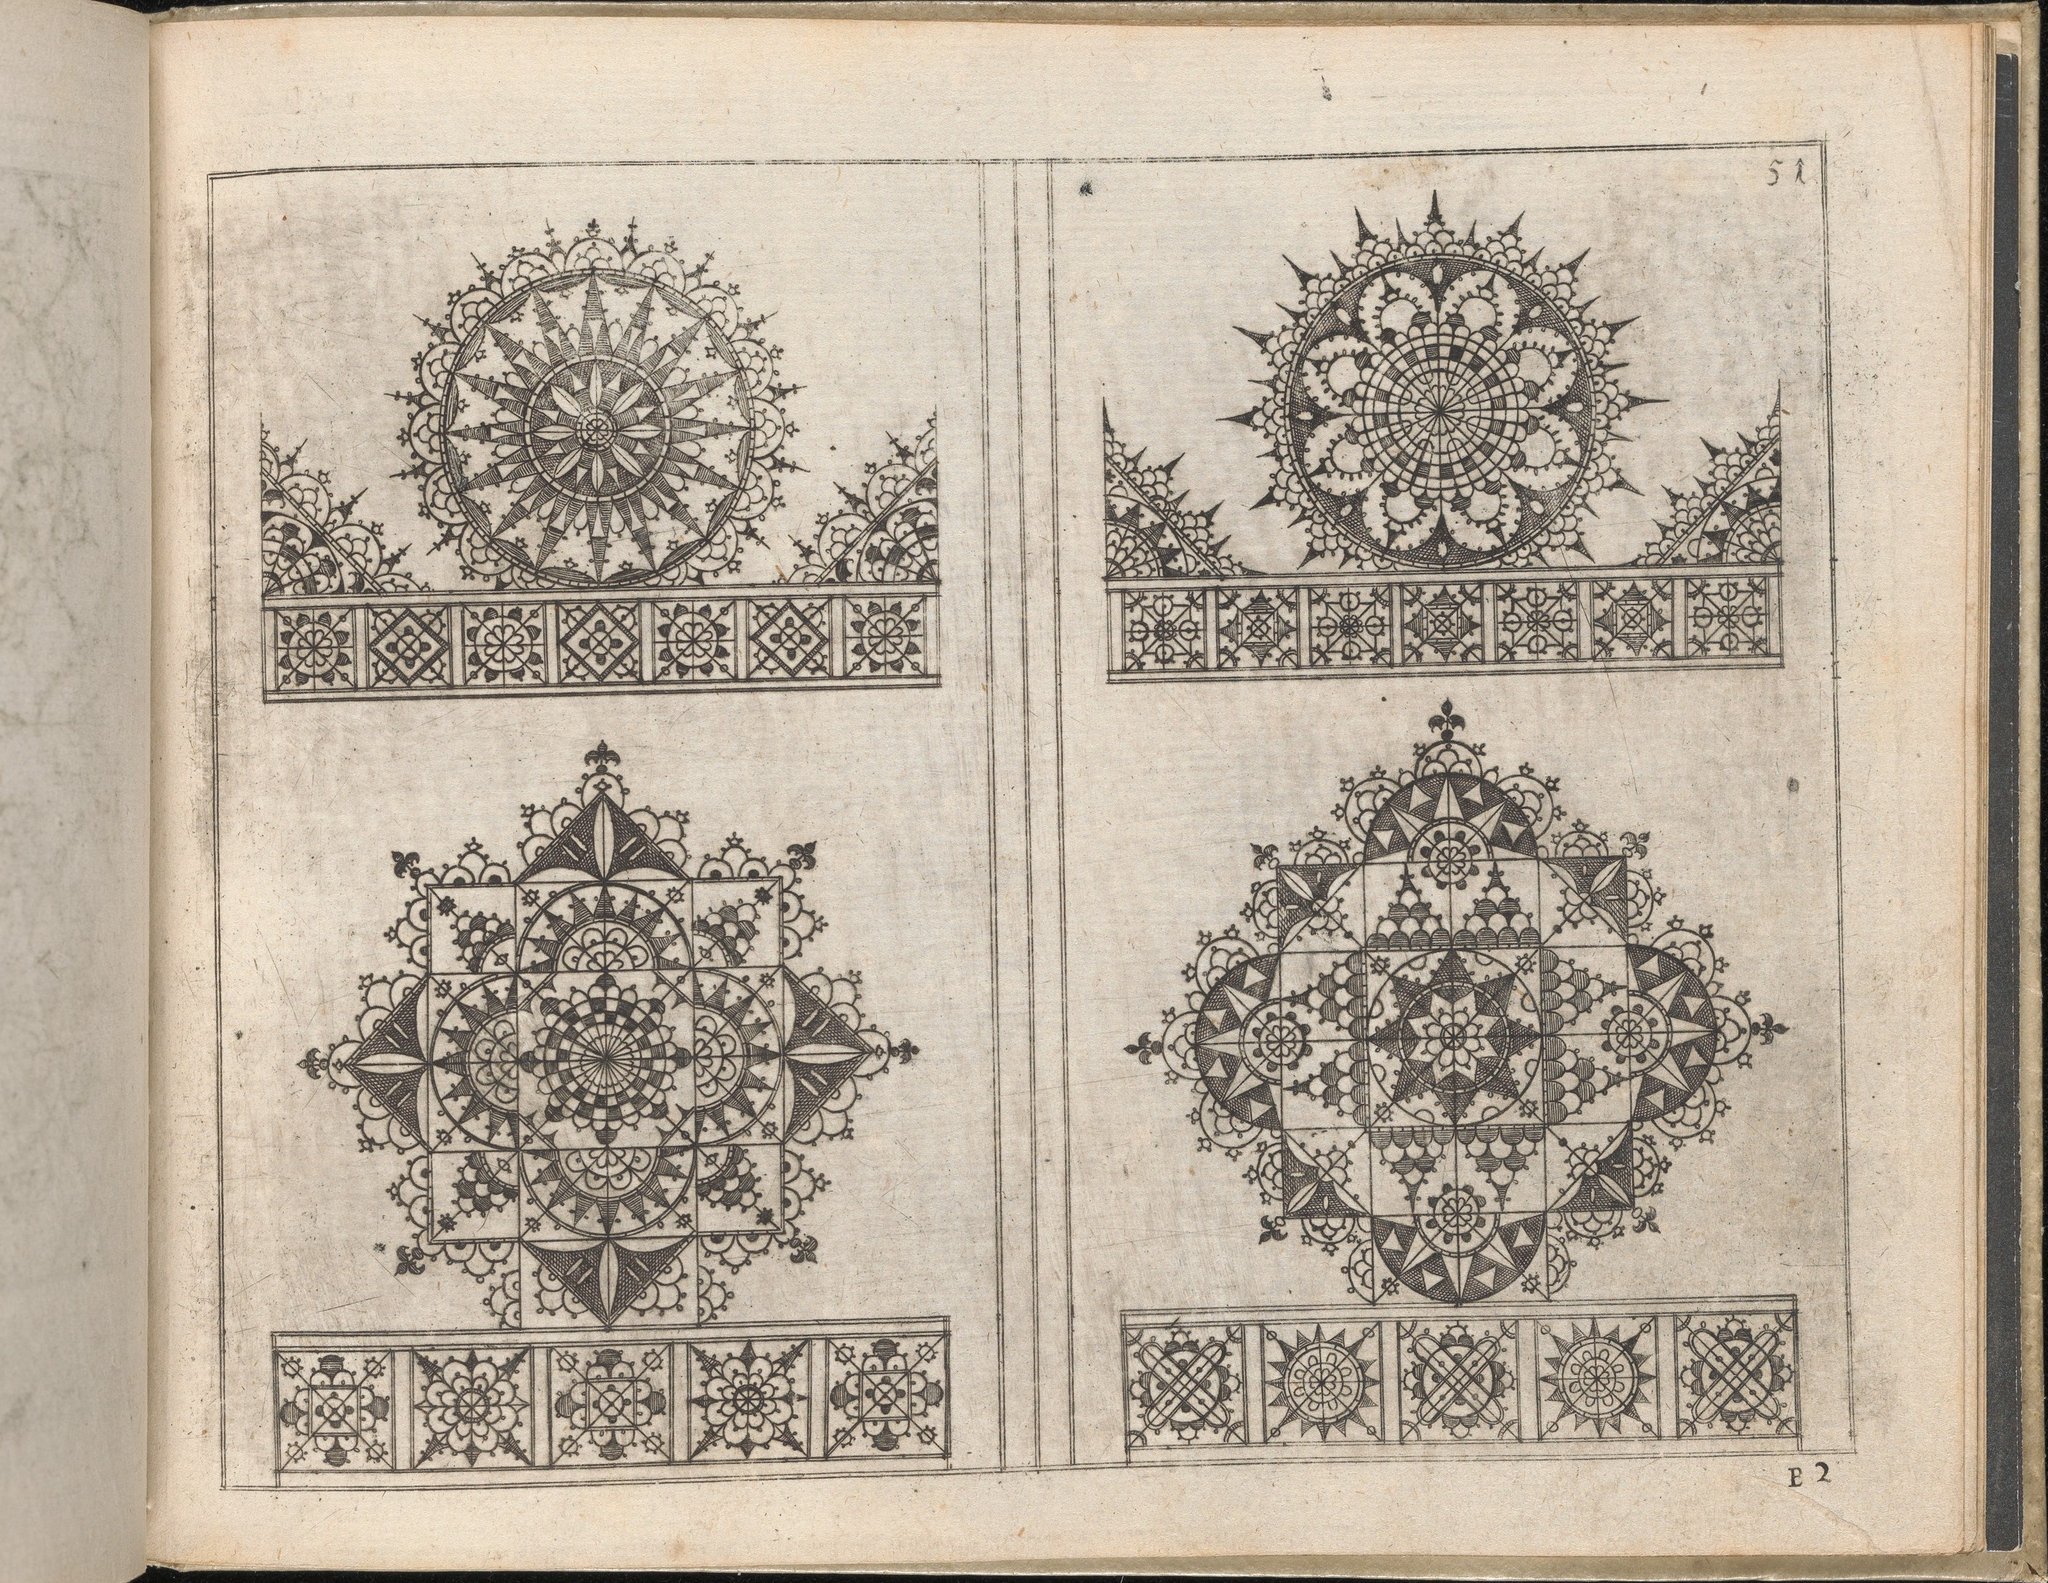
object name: book print ornament architecture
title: Newes Modelbuch in Kupffer (Page 60r)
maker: johann sibmacher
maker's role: artist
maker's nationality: german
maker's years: 1590-1611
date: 1604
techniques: etching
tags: flowers